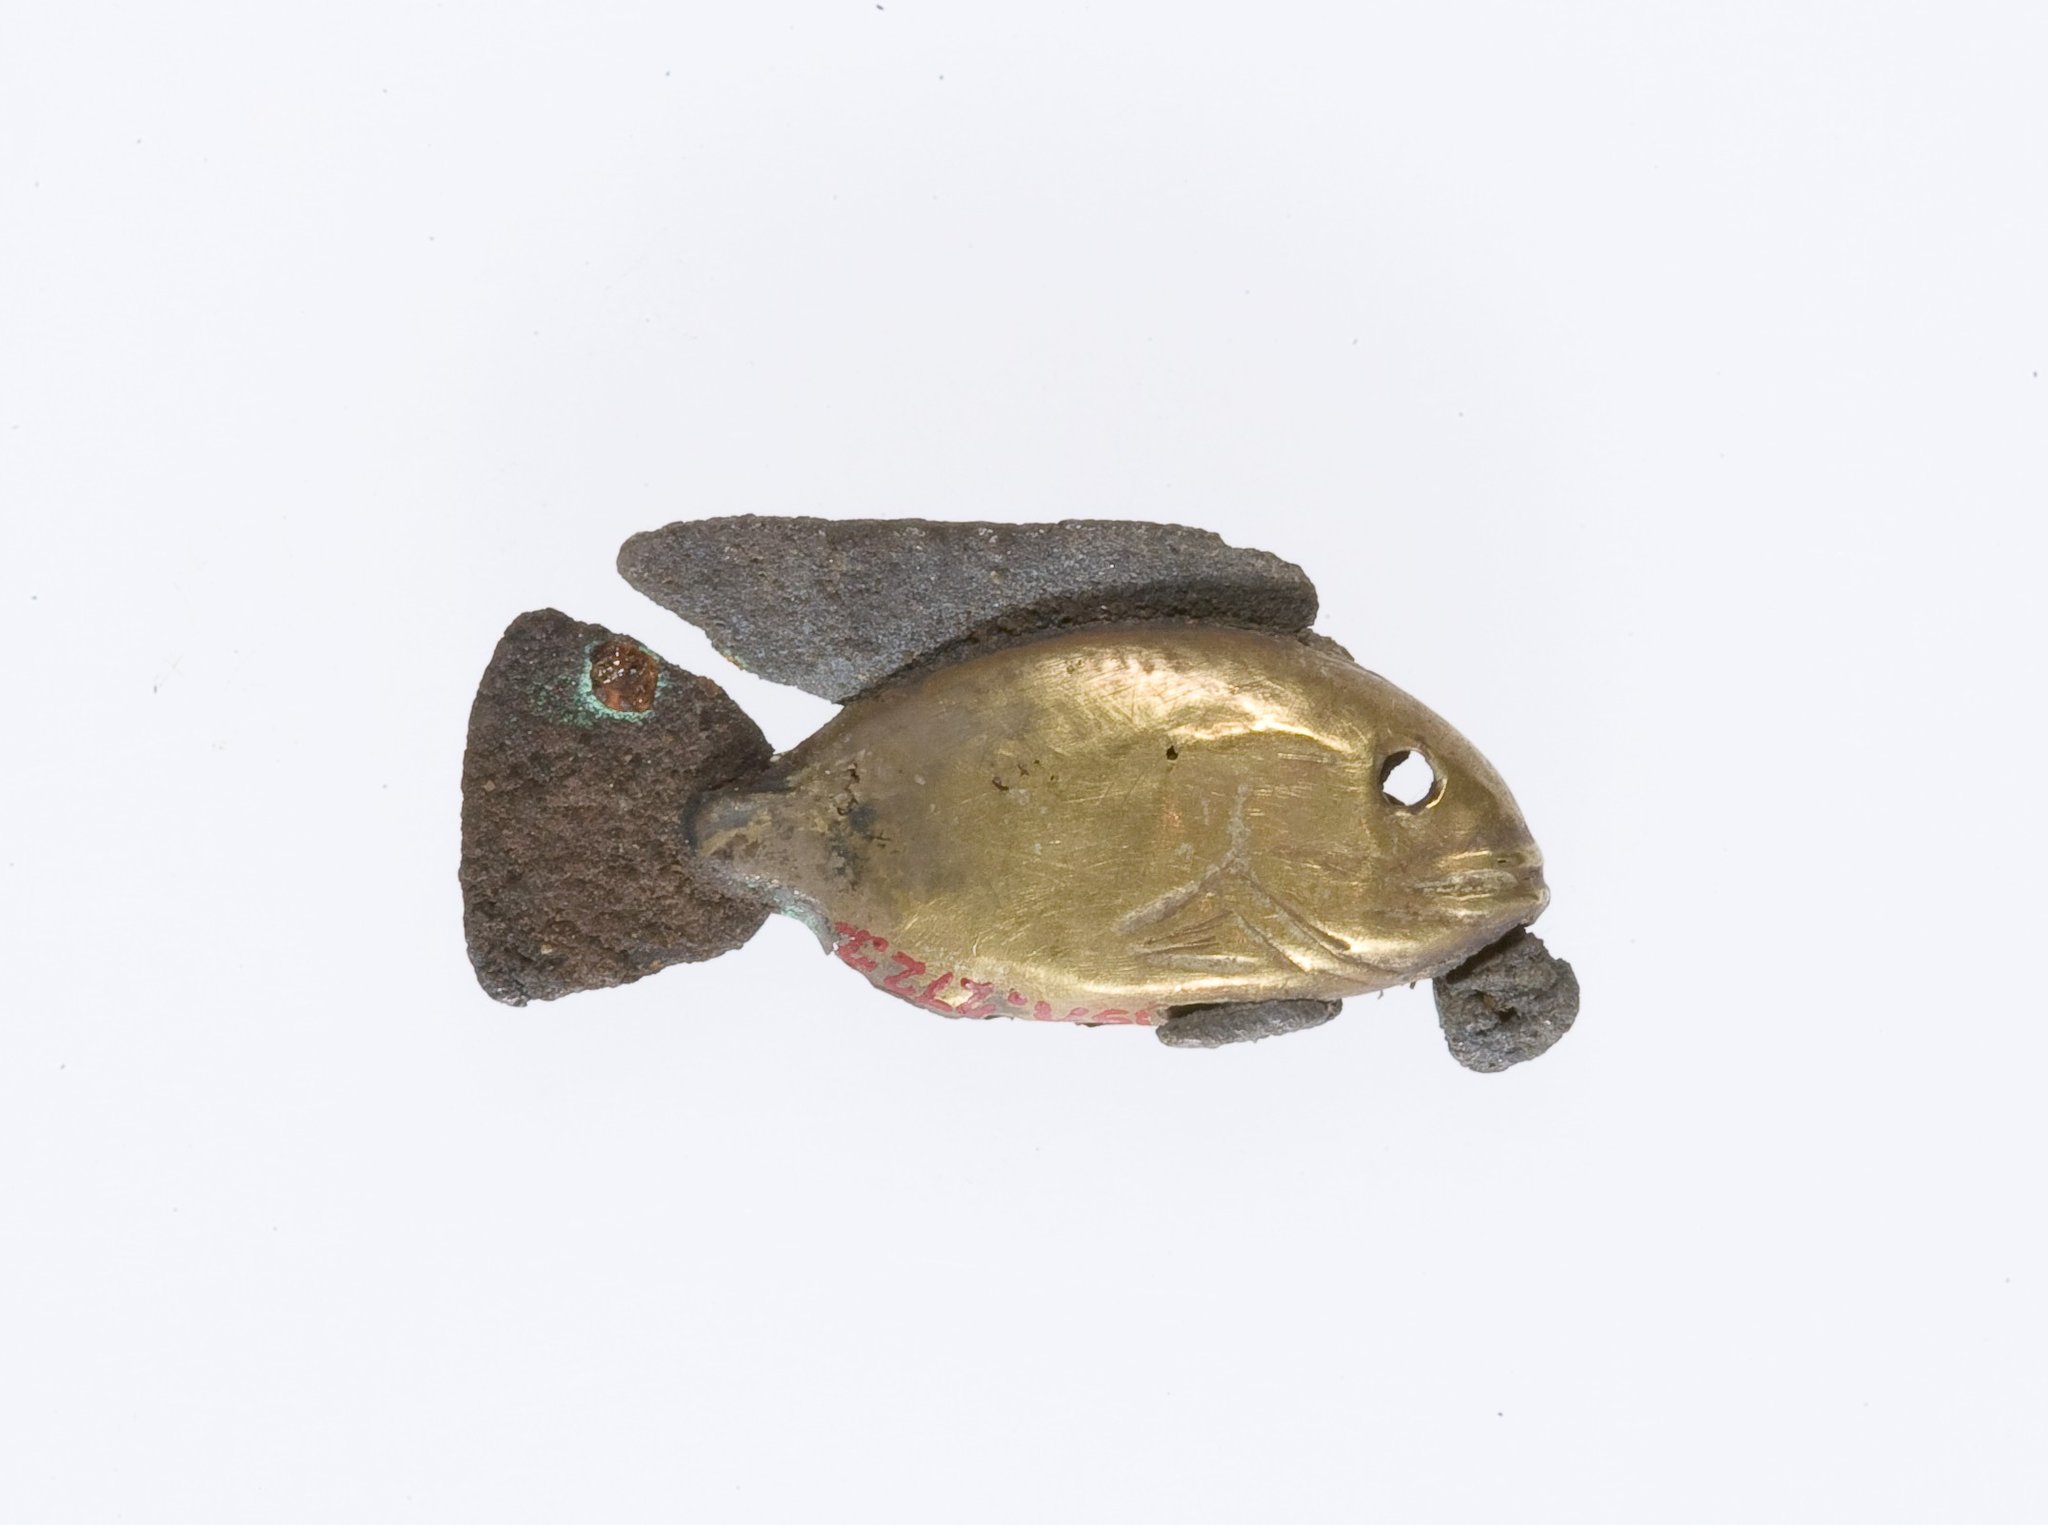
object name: pendant, fish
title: Fish Pendant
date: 1981-1650 BCE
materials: gold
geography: egypt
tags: fish